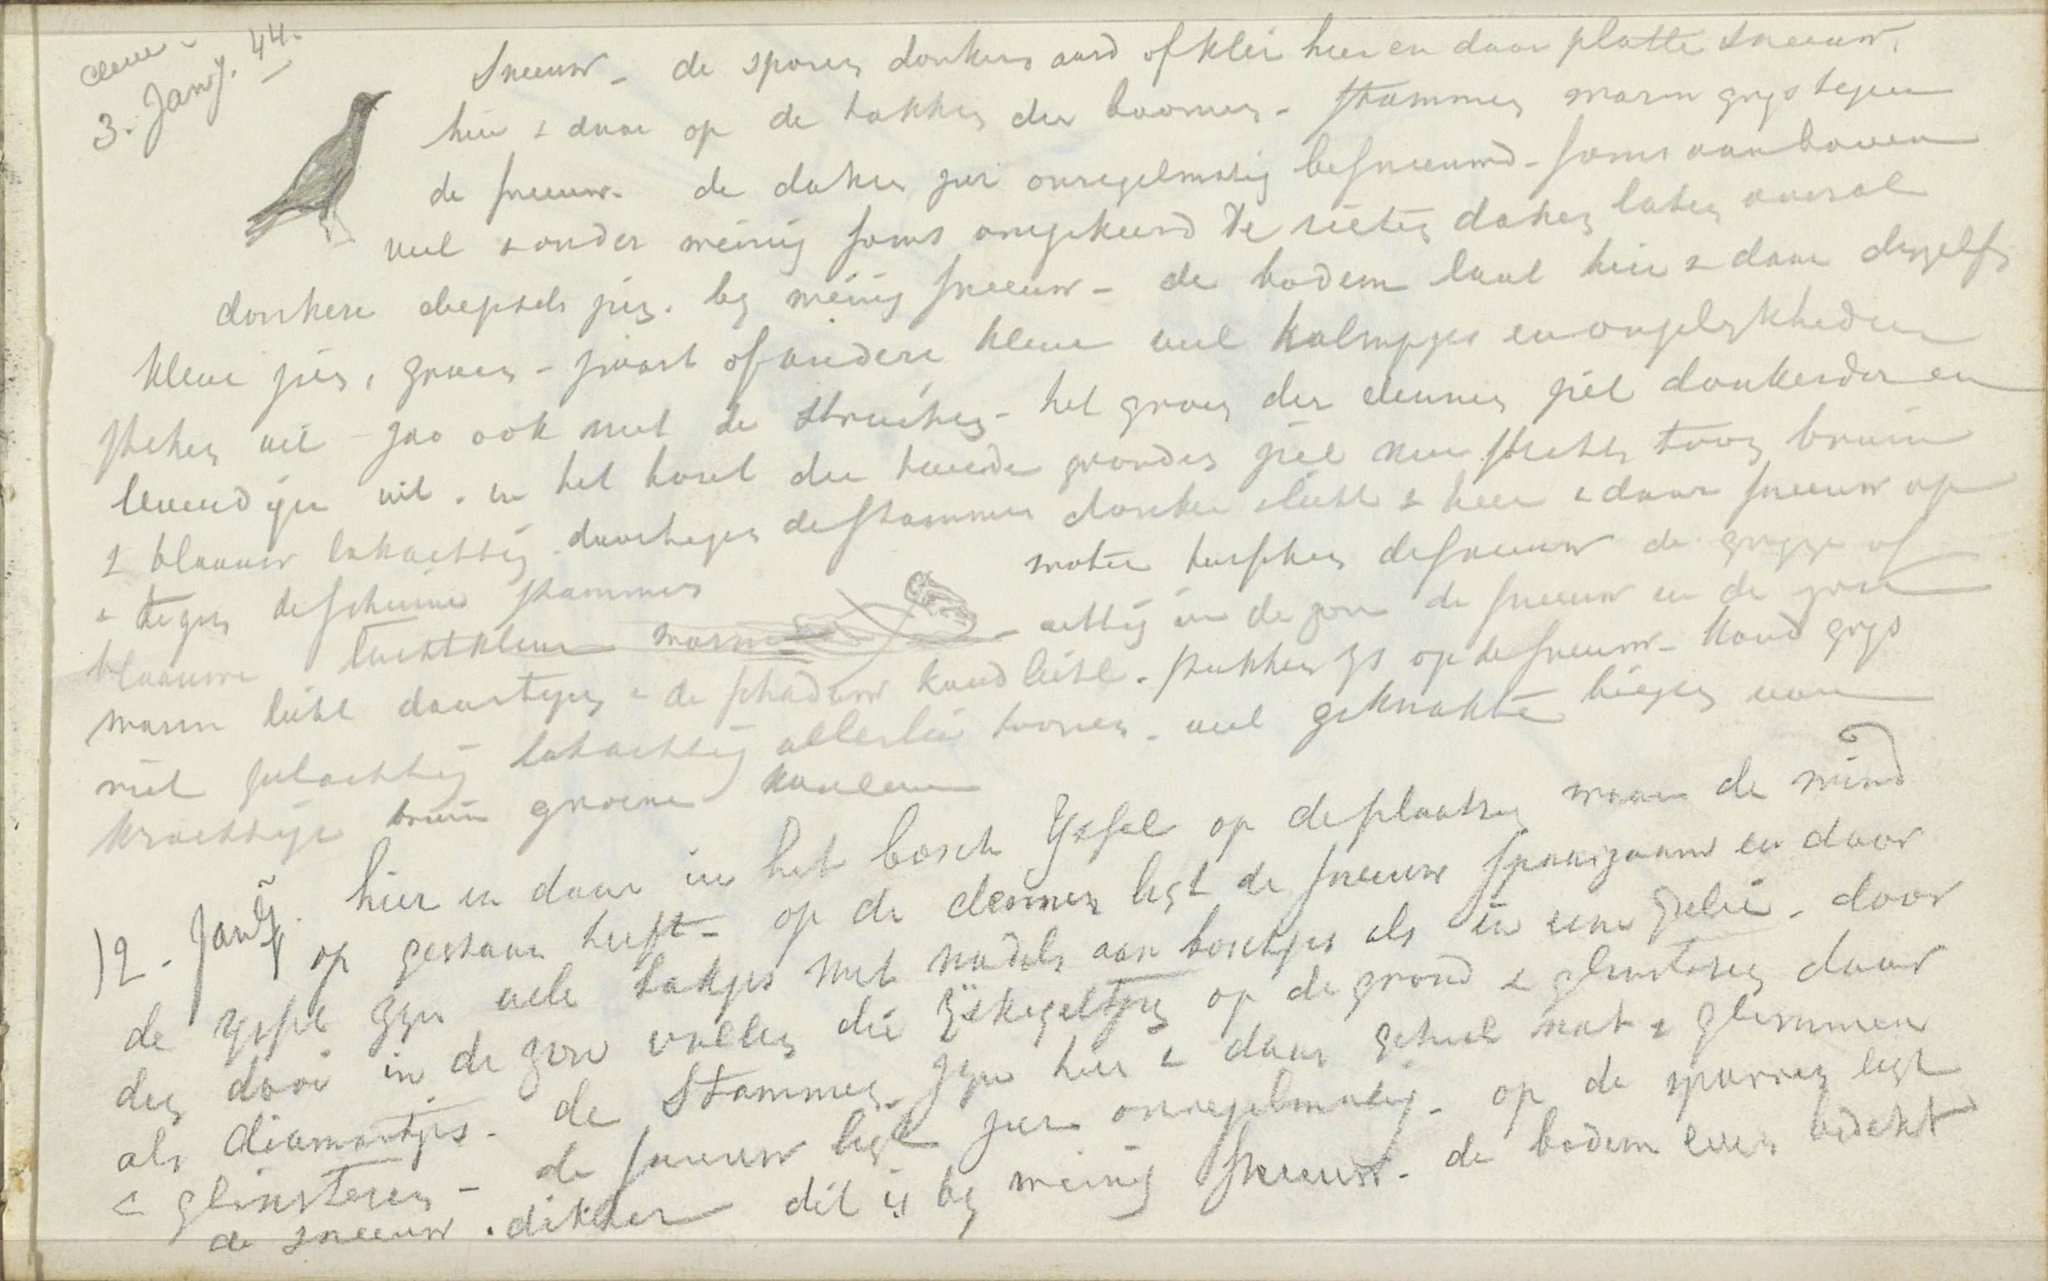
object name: sketchbook leaf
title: Vogel en een eend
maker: johannes tavenraat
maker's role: draughtsman, painter, print maker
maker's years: 1809-1881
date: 1801-1844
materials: paper, pencil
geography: cleves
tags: birds, water-birds: duck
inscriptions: date and inscription: ‘cleve/ 3. Jan y. 44./[...] 12. Jan ij’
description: Blad 37 recto uit een schetsboek met 38 bladen.